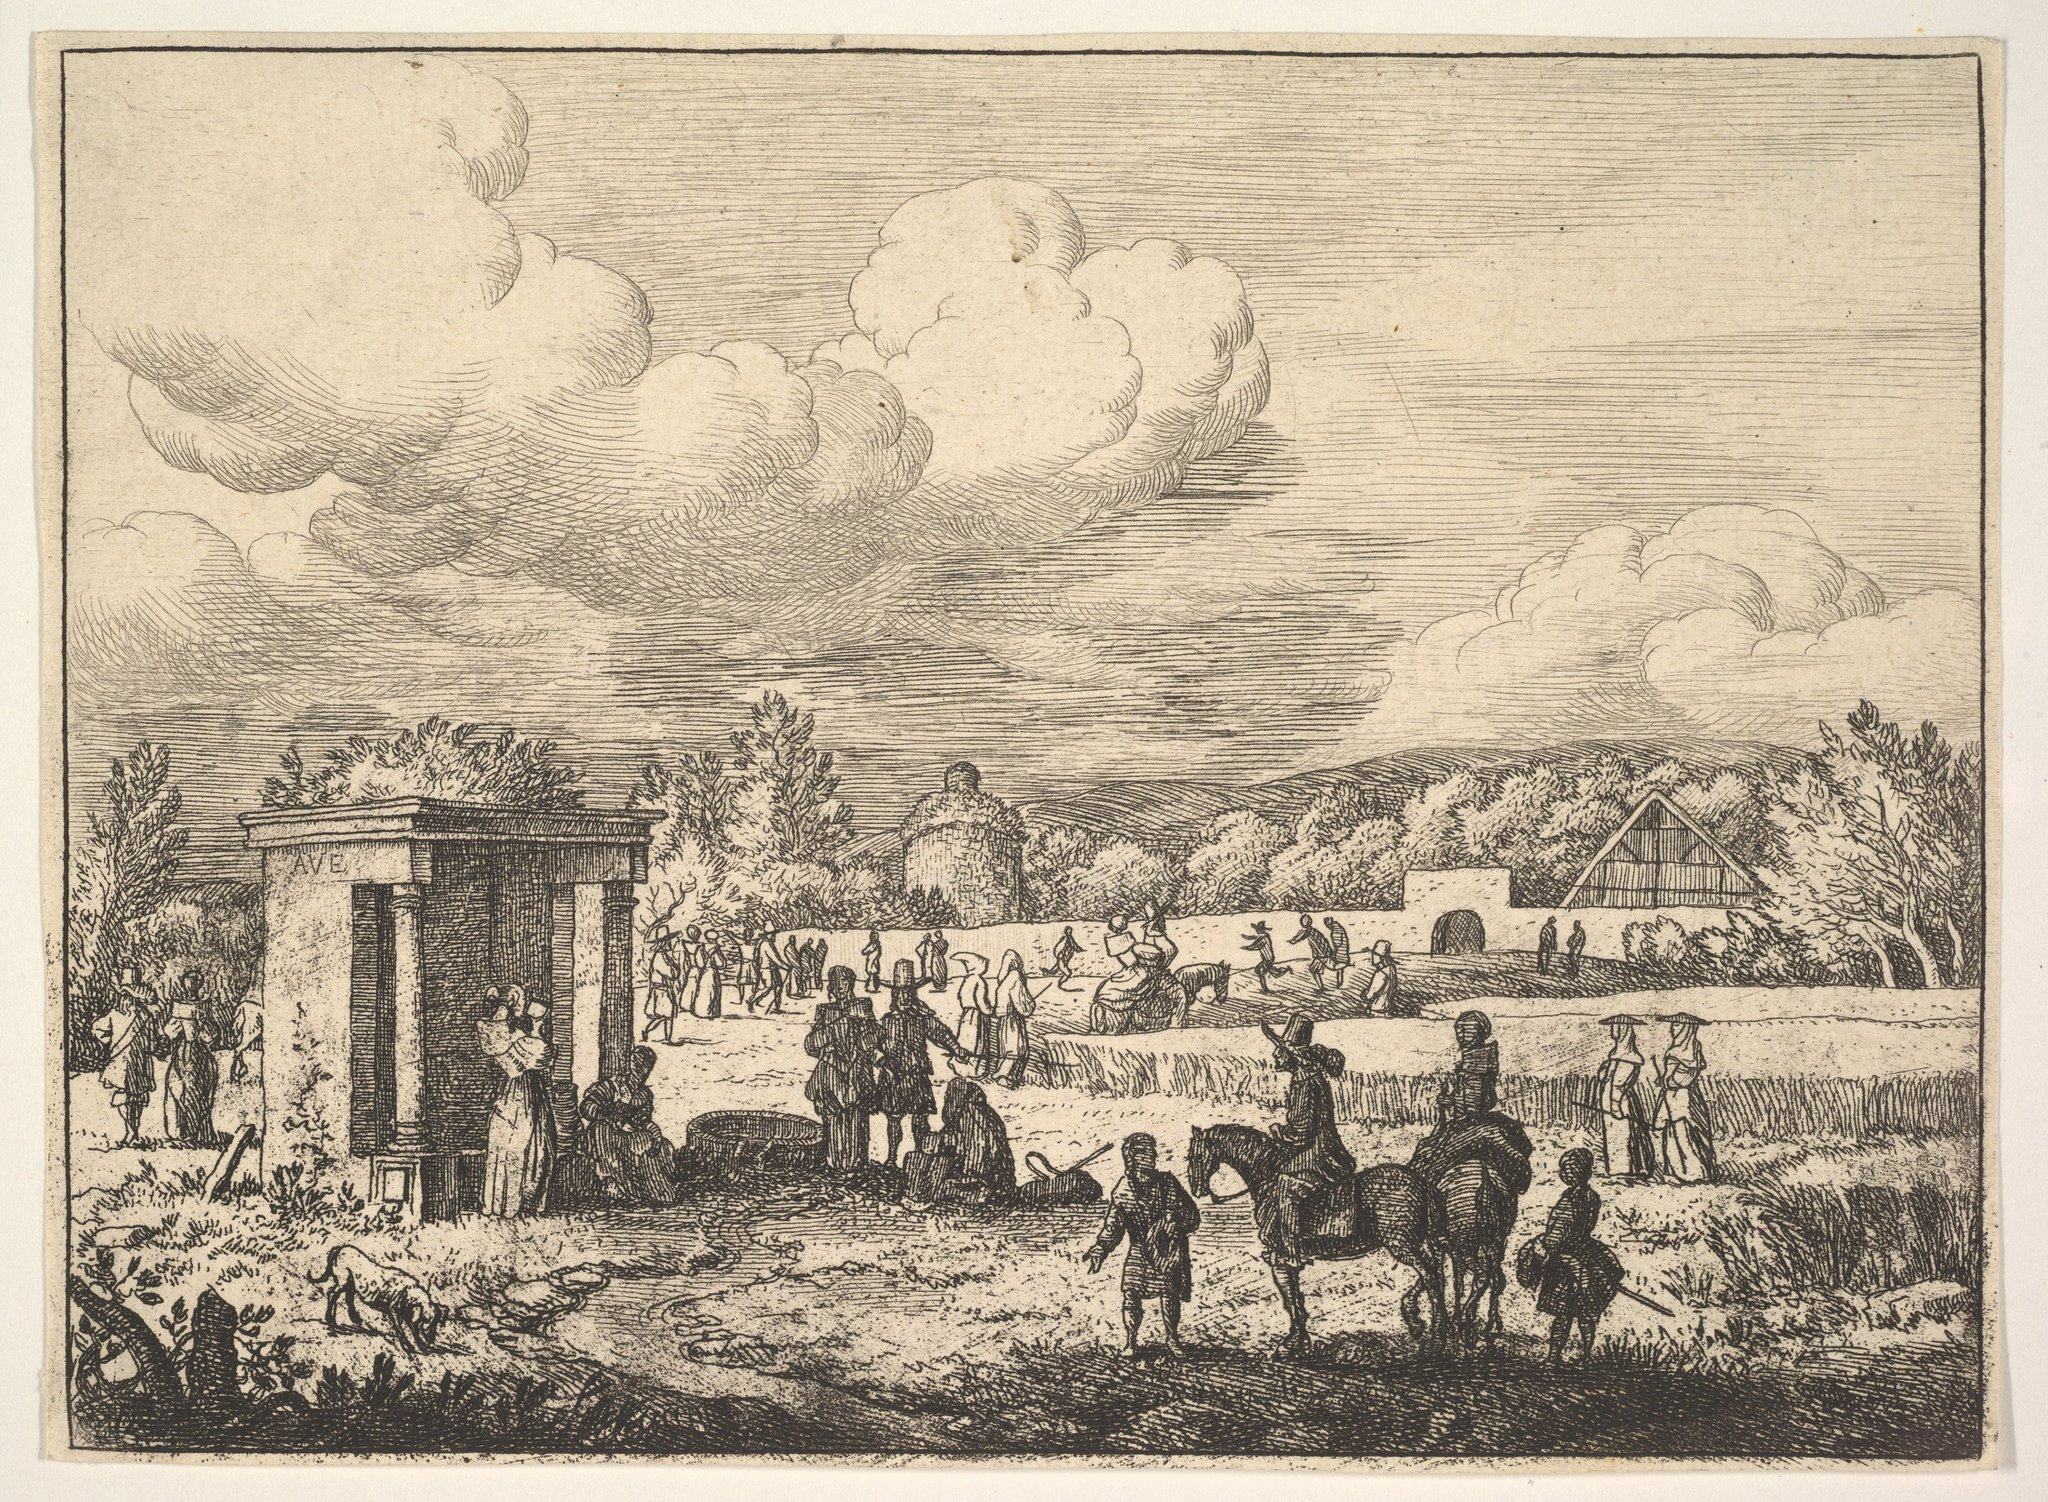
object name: print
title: The First Spring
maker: allart van everdingen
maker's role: artist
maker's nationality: dutch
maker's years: 1621-1675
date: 1640-1675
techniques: etching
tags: men,horses,trees